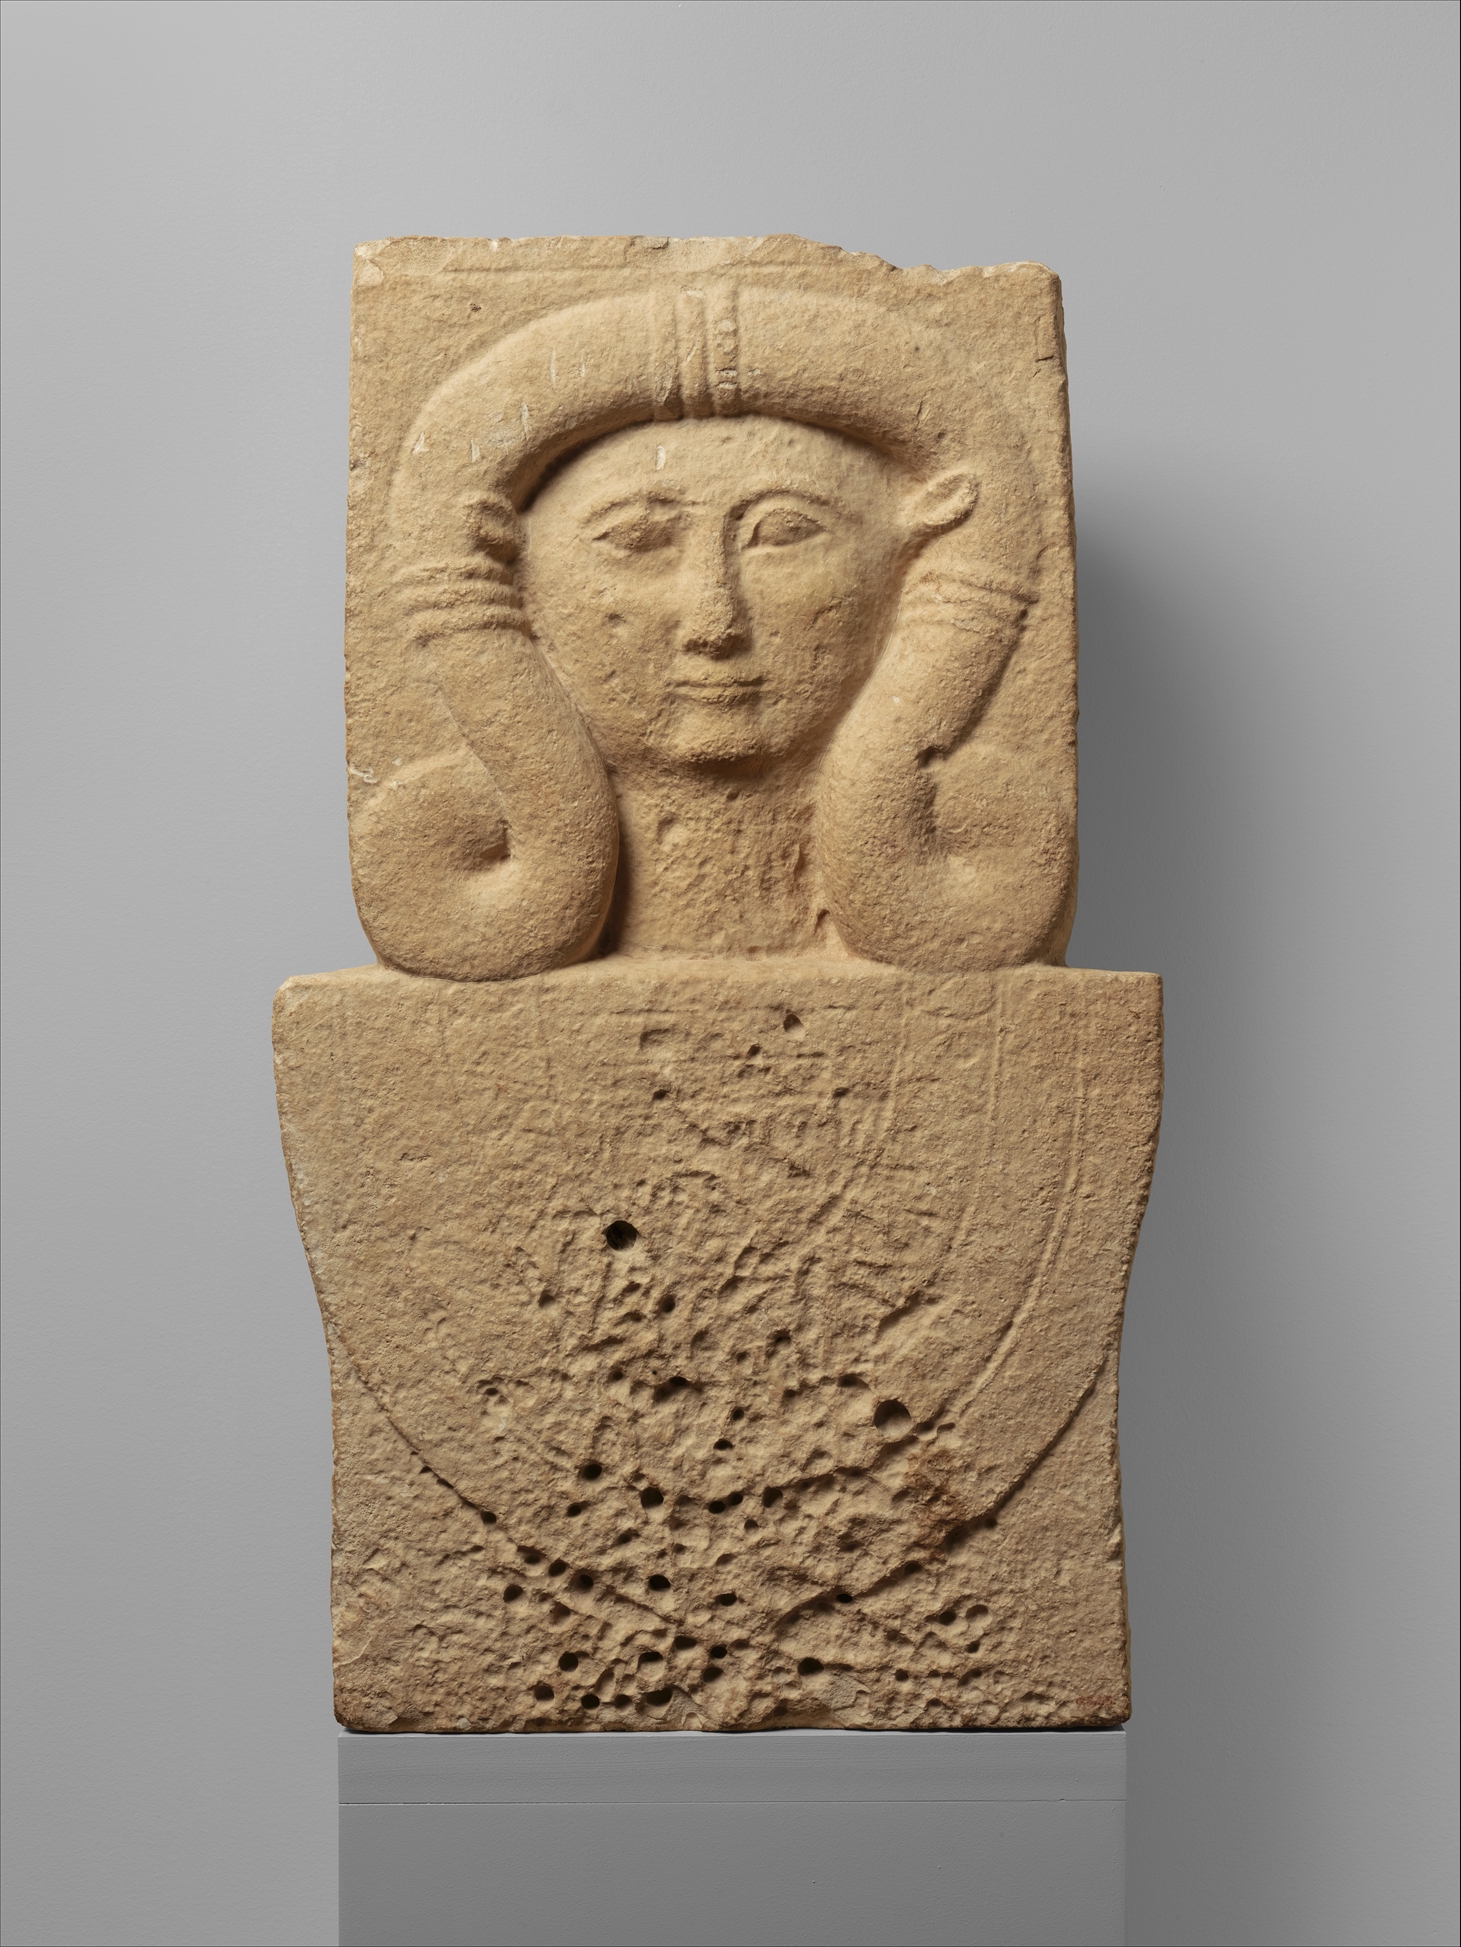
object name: grave stele with head of hathor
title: Limestone stele (shaft) with the head of Hathor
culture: cypriot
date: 575-551 BCE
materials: limestone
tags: heads,hathor